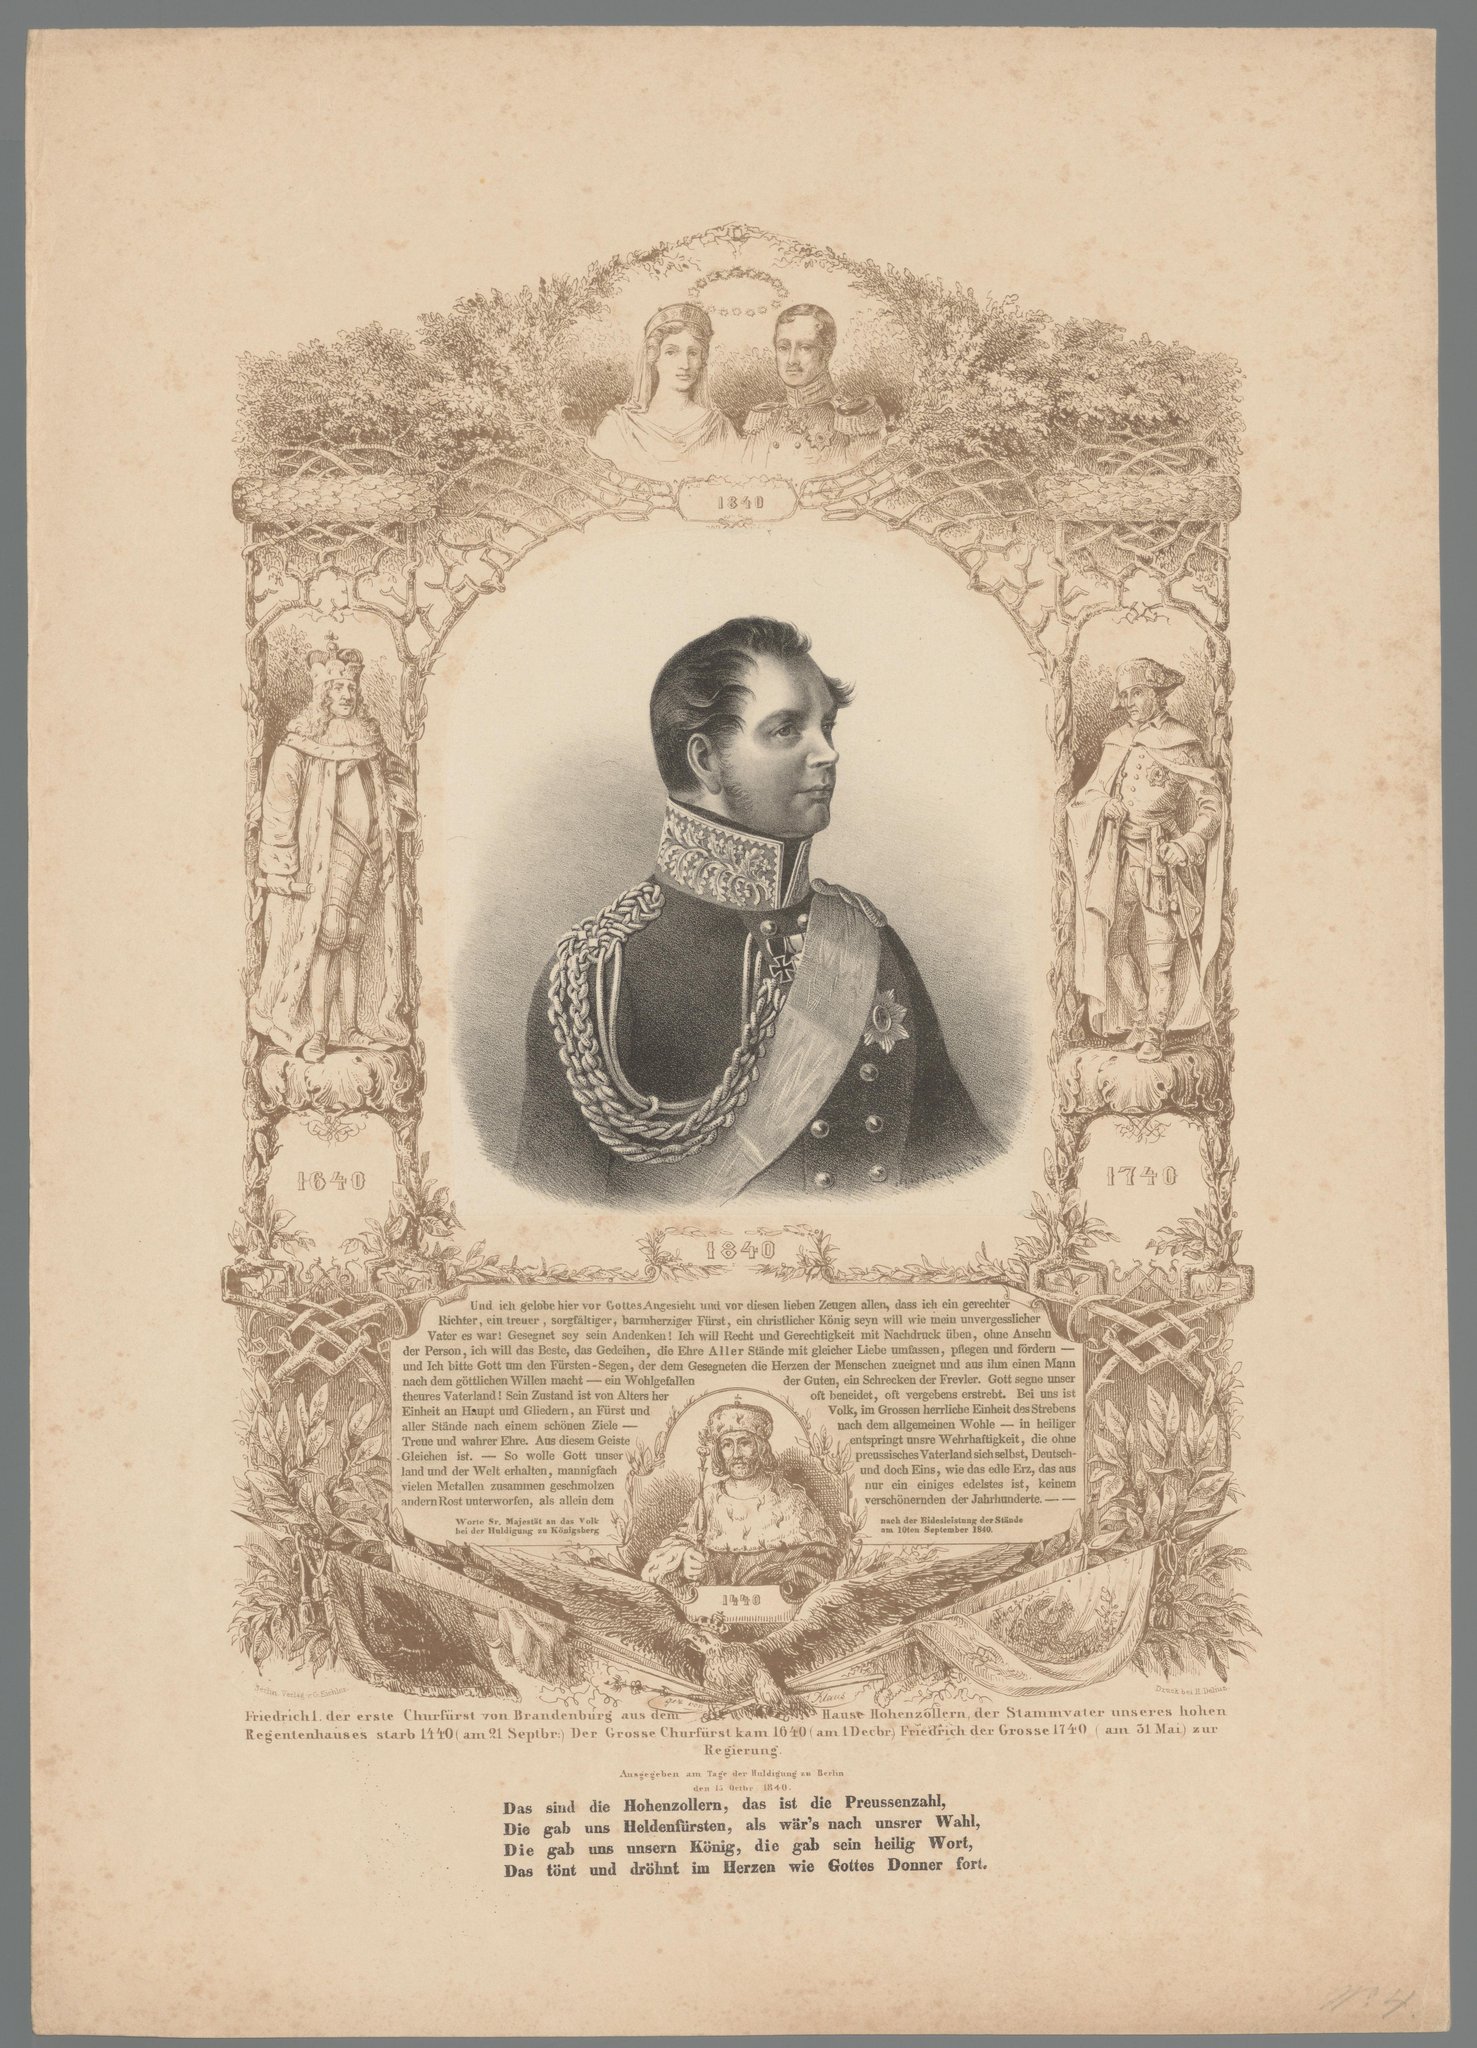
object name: print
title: Portret van Frederik Willem IV, koning van Pruisen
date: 1840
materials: paper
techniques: lithograph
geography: berlin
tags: berlin, frederik willem iv (koning van pruisen), adult man, historical persons, ranks ~ rulers, sovereigns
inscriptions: collector's mark: Lugt 2228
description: Ornamenteel kader om het portret en tekst midden onder. In het kader zijn de voorgaande vorsten van Pruisen afgebeeld.